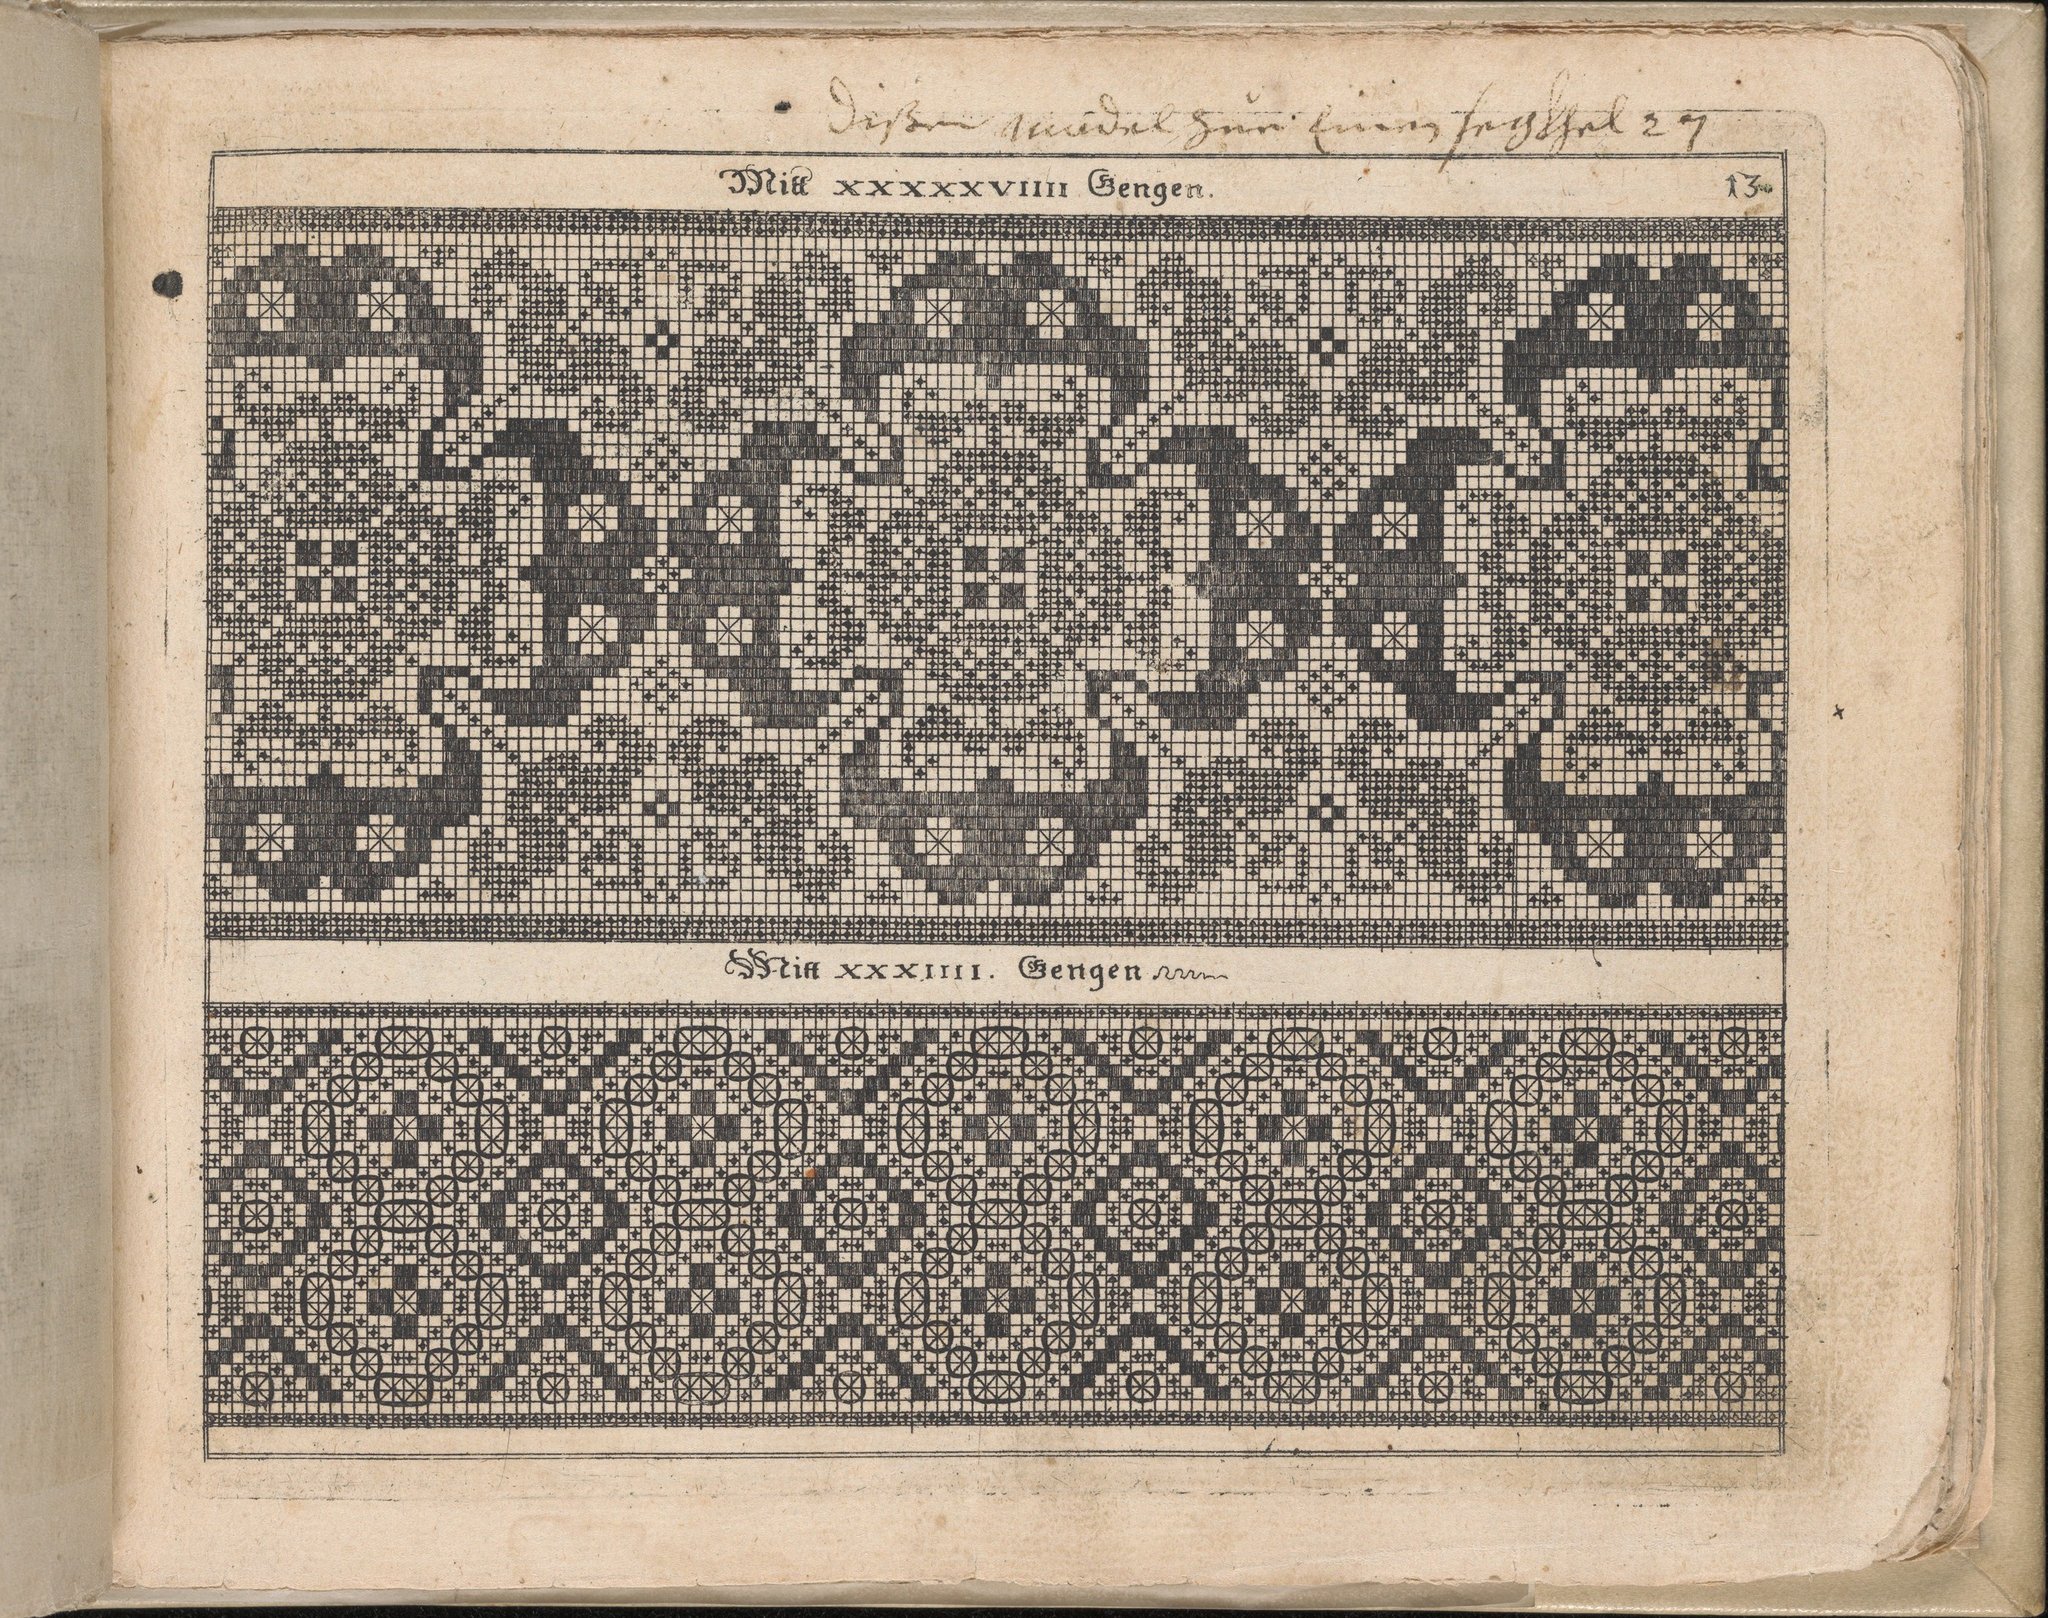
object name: book print ornament architecture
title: Schön Neues Modelbuch (Page 18 recto)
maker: johann sibmacher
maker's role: designer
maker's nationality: german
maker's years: 1590-1611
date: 1597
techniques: etching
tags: ornament